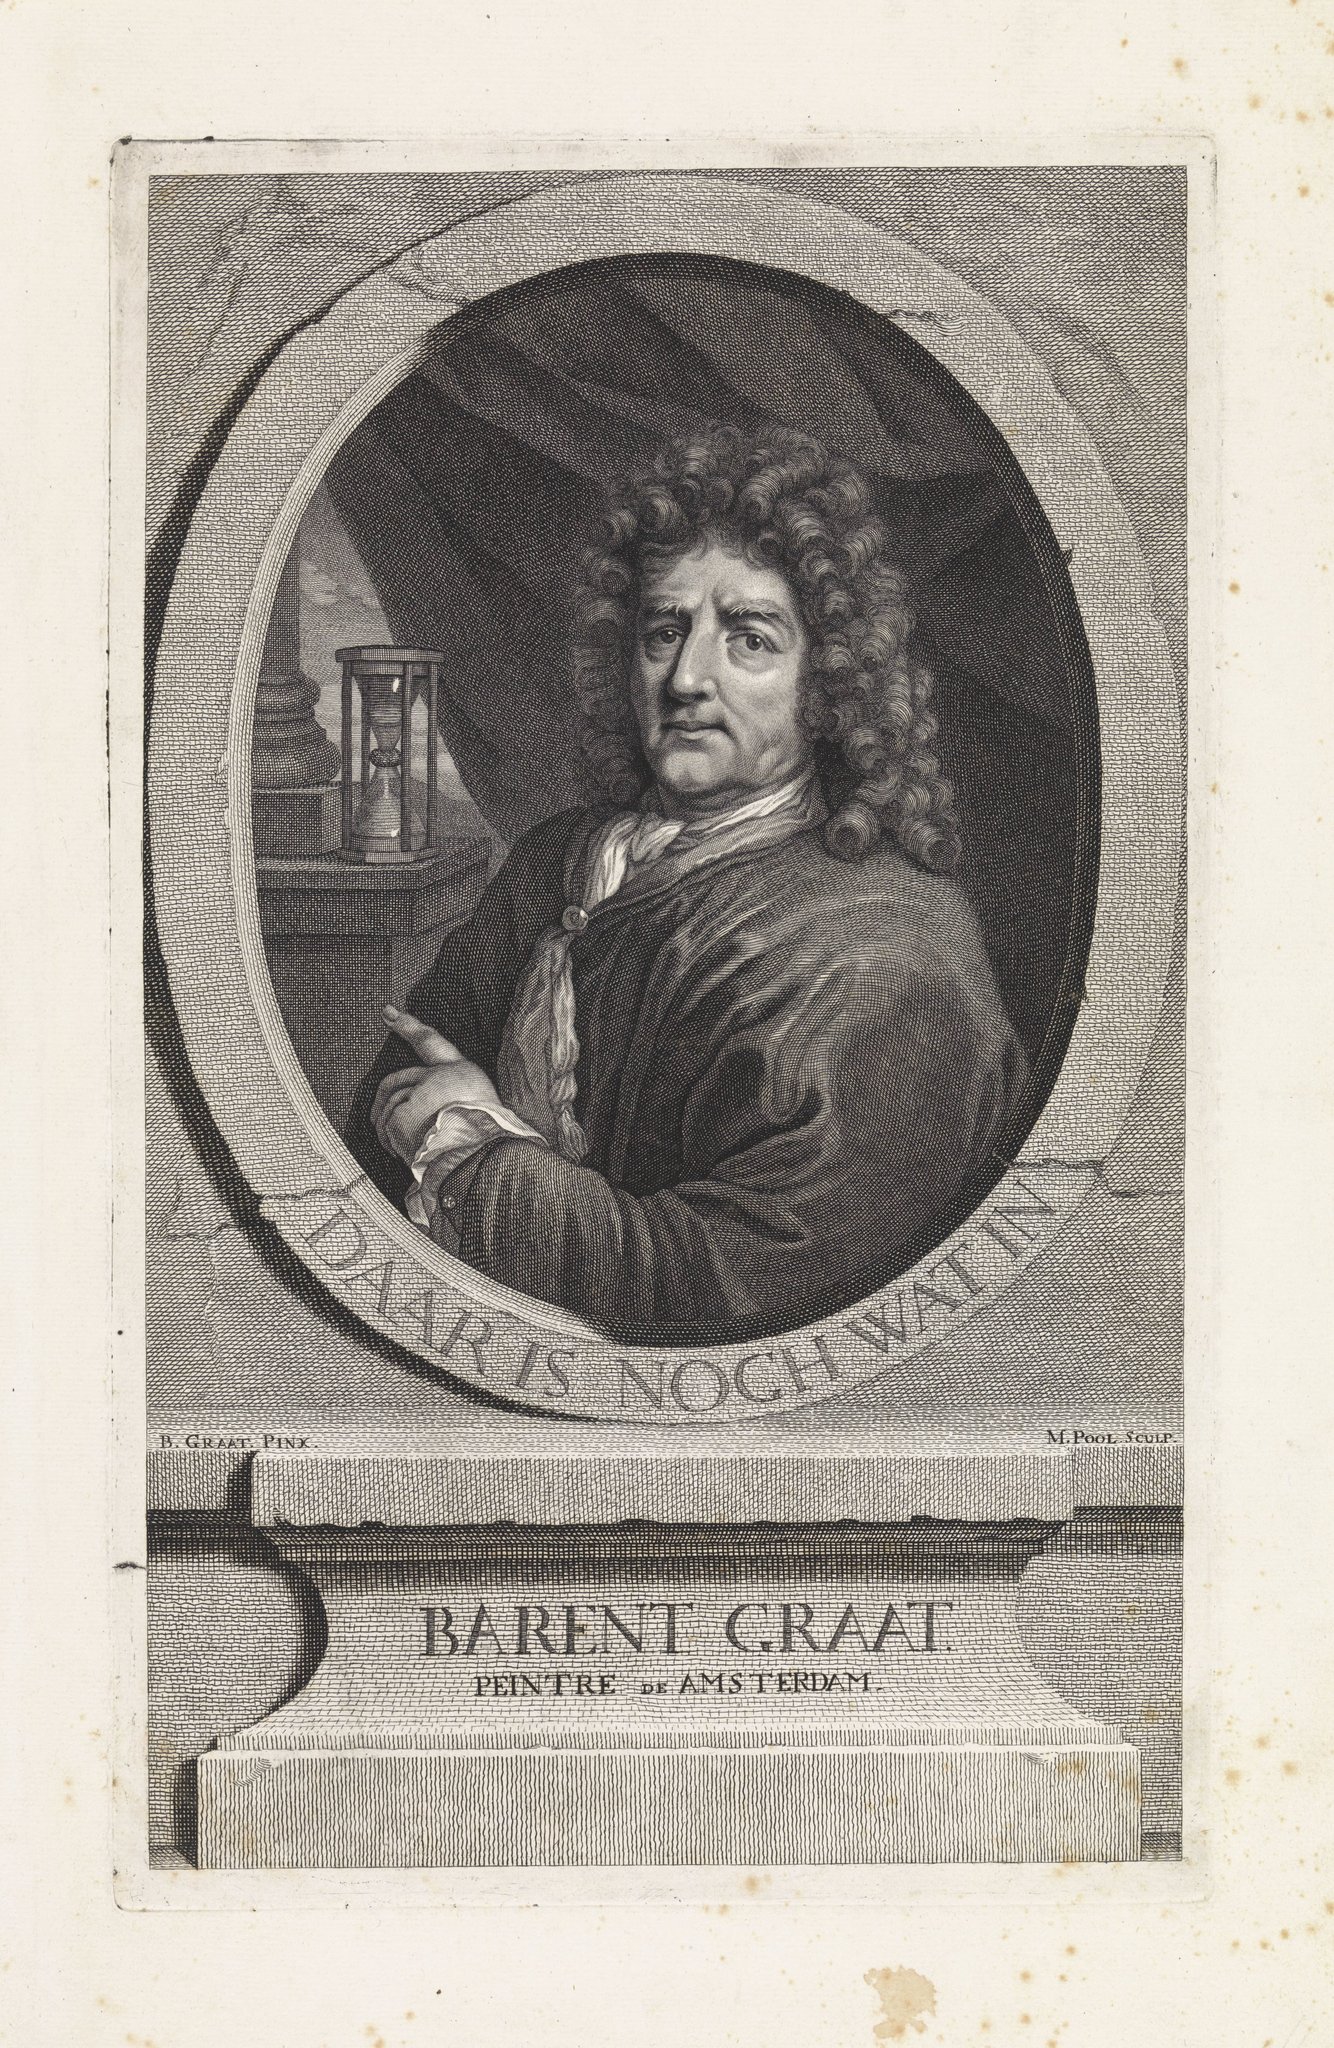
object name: print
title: Portret van de schilder Barend Graat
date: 1696-1727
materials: paper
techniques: engraving, etching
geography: amsterdam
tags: amsterdam, draughtsman, barend graat, portrait, self-portrait of painter, hourglass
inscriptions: collector's mark: Lugt 240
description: Portret van de schilder Barend Graat. Met zijn linkerhand wijst hij op een zandloper.